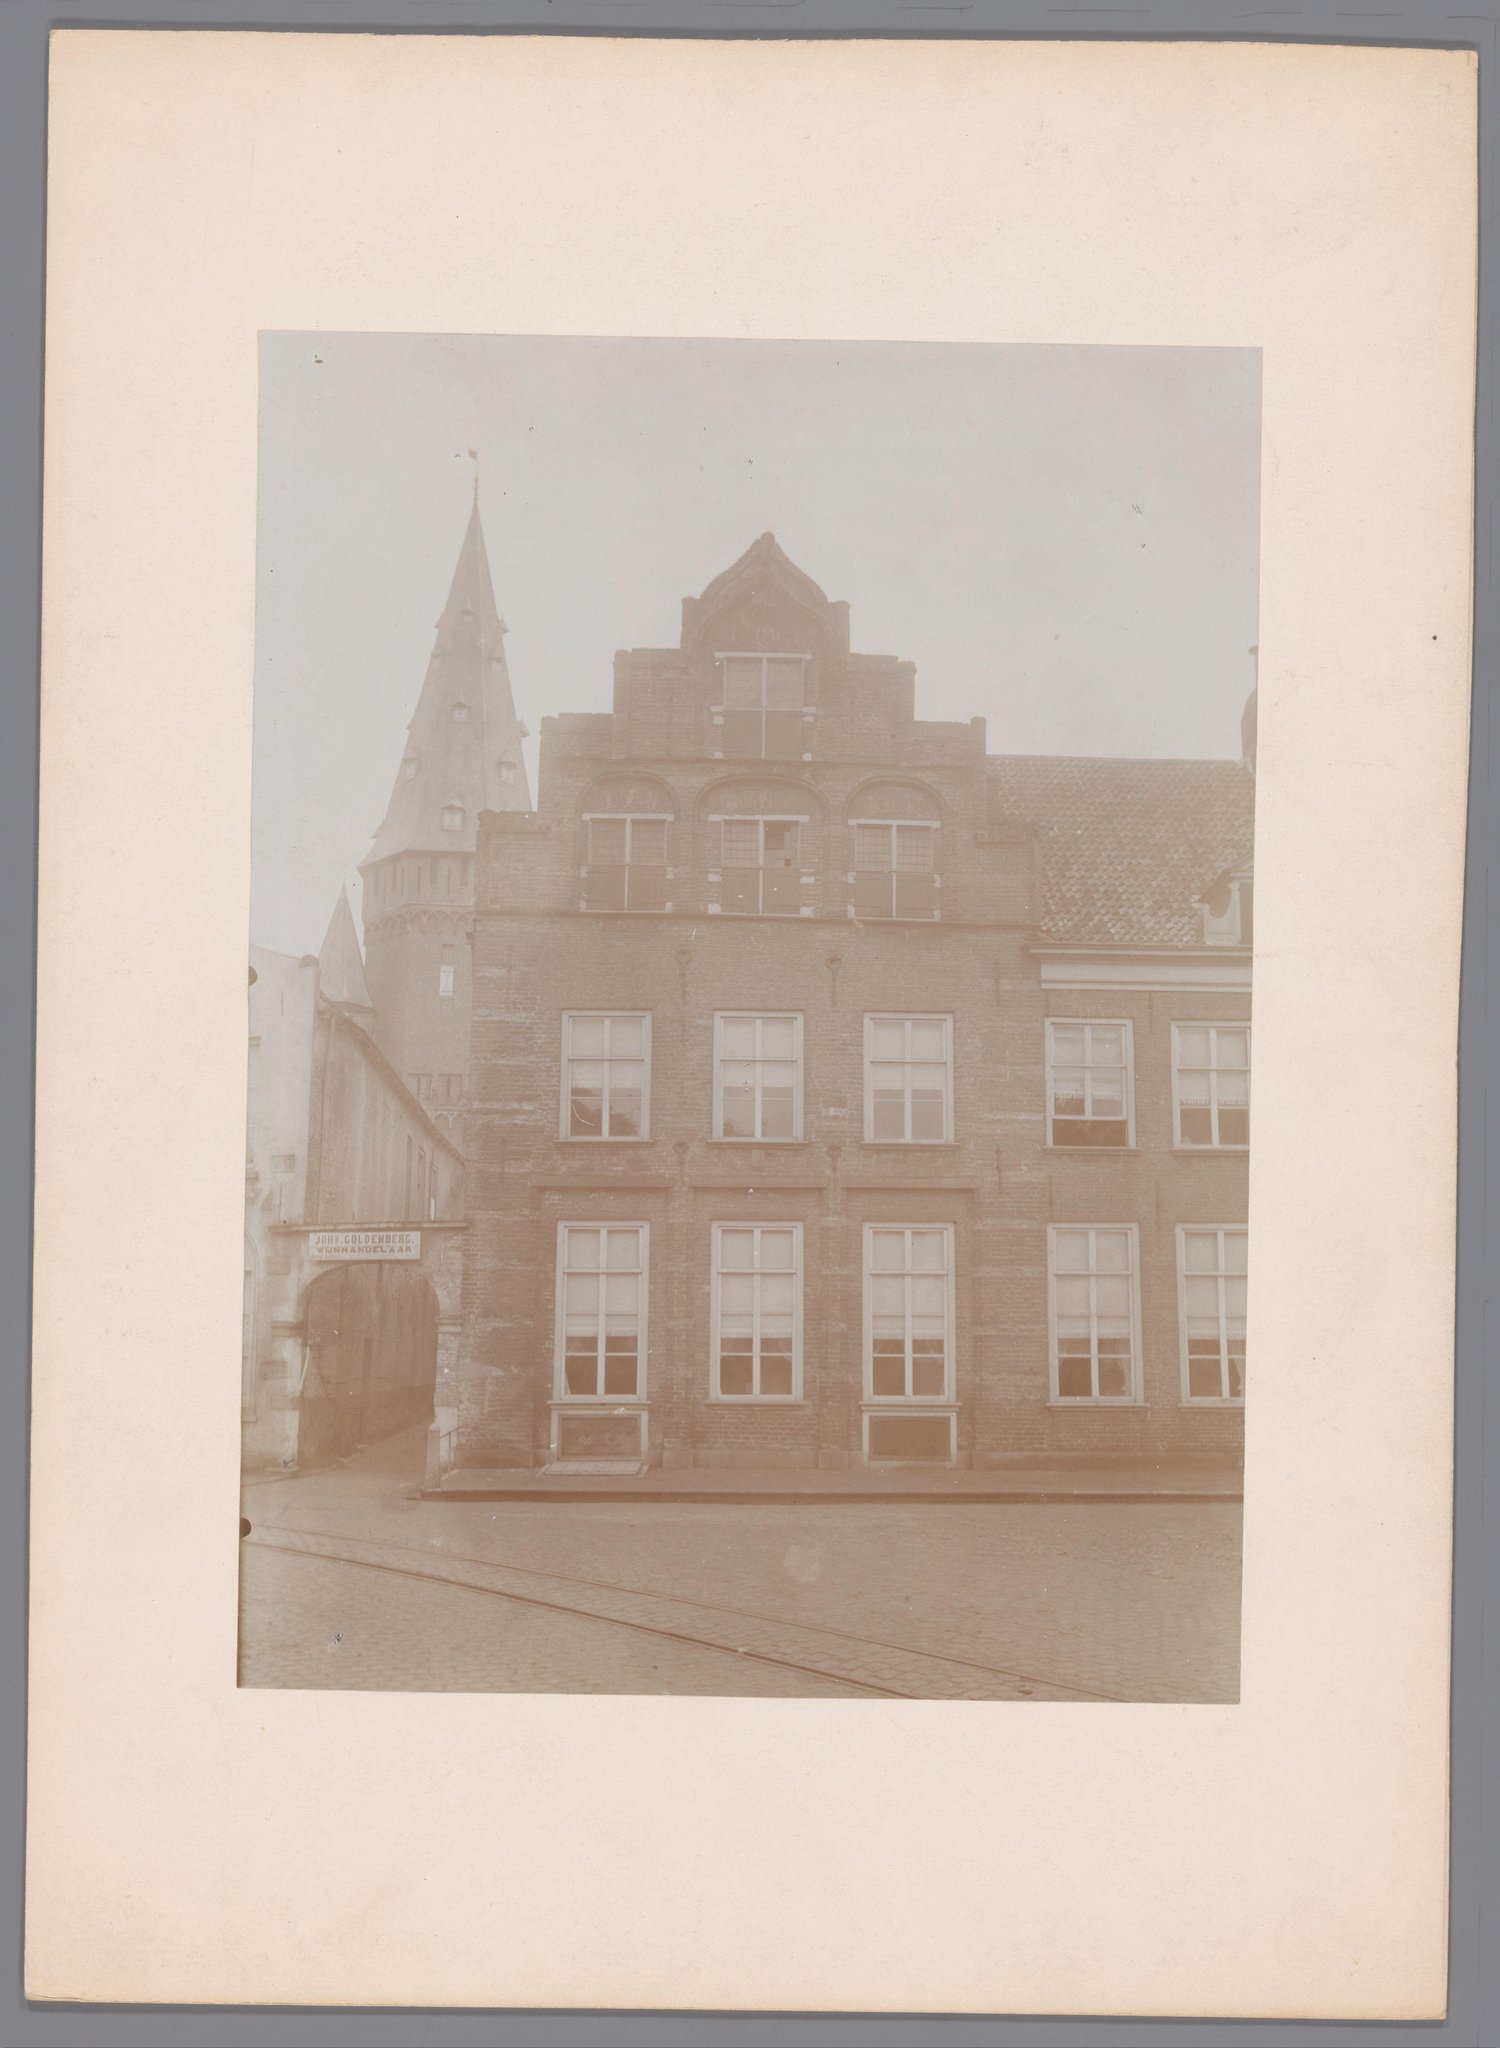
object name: photograph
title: Gezicht op Zaadmarkt 19 te Zutphen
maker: anoniem (monumentenzorg)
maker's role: fotograaf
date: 1905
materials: cardboard, photographic support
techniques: collodion silver print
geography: zutphen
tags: urban housing, façade (of house or building), street (+ city(-scape) with figures, staffage)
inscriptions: annotation: ‘Woonhuis. Zaadmarkt 19-/ Zutphen (G.)/ Dec: 1905’